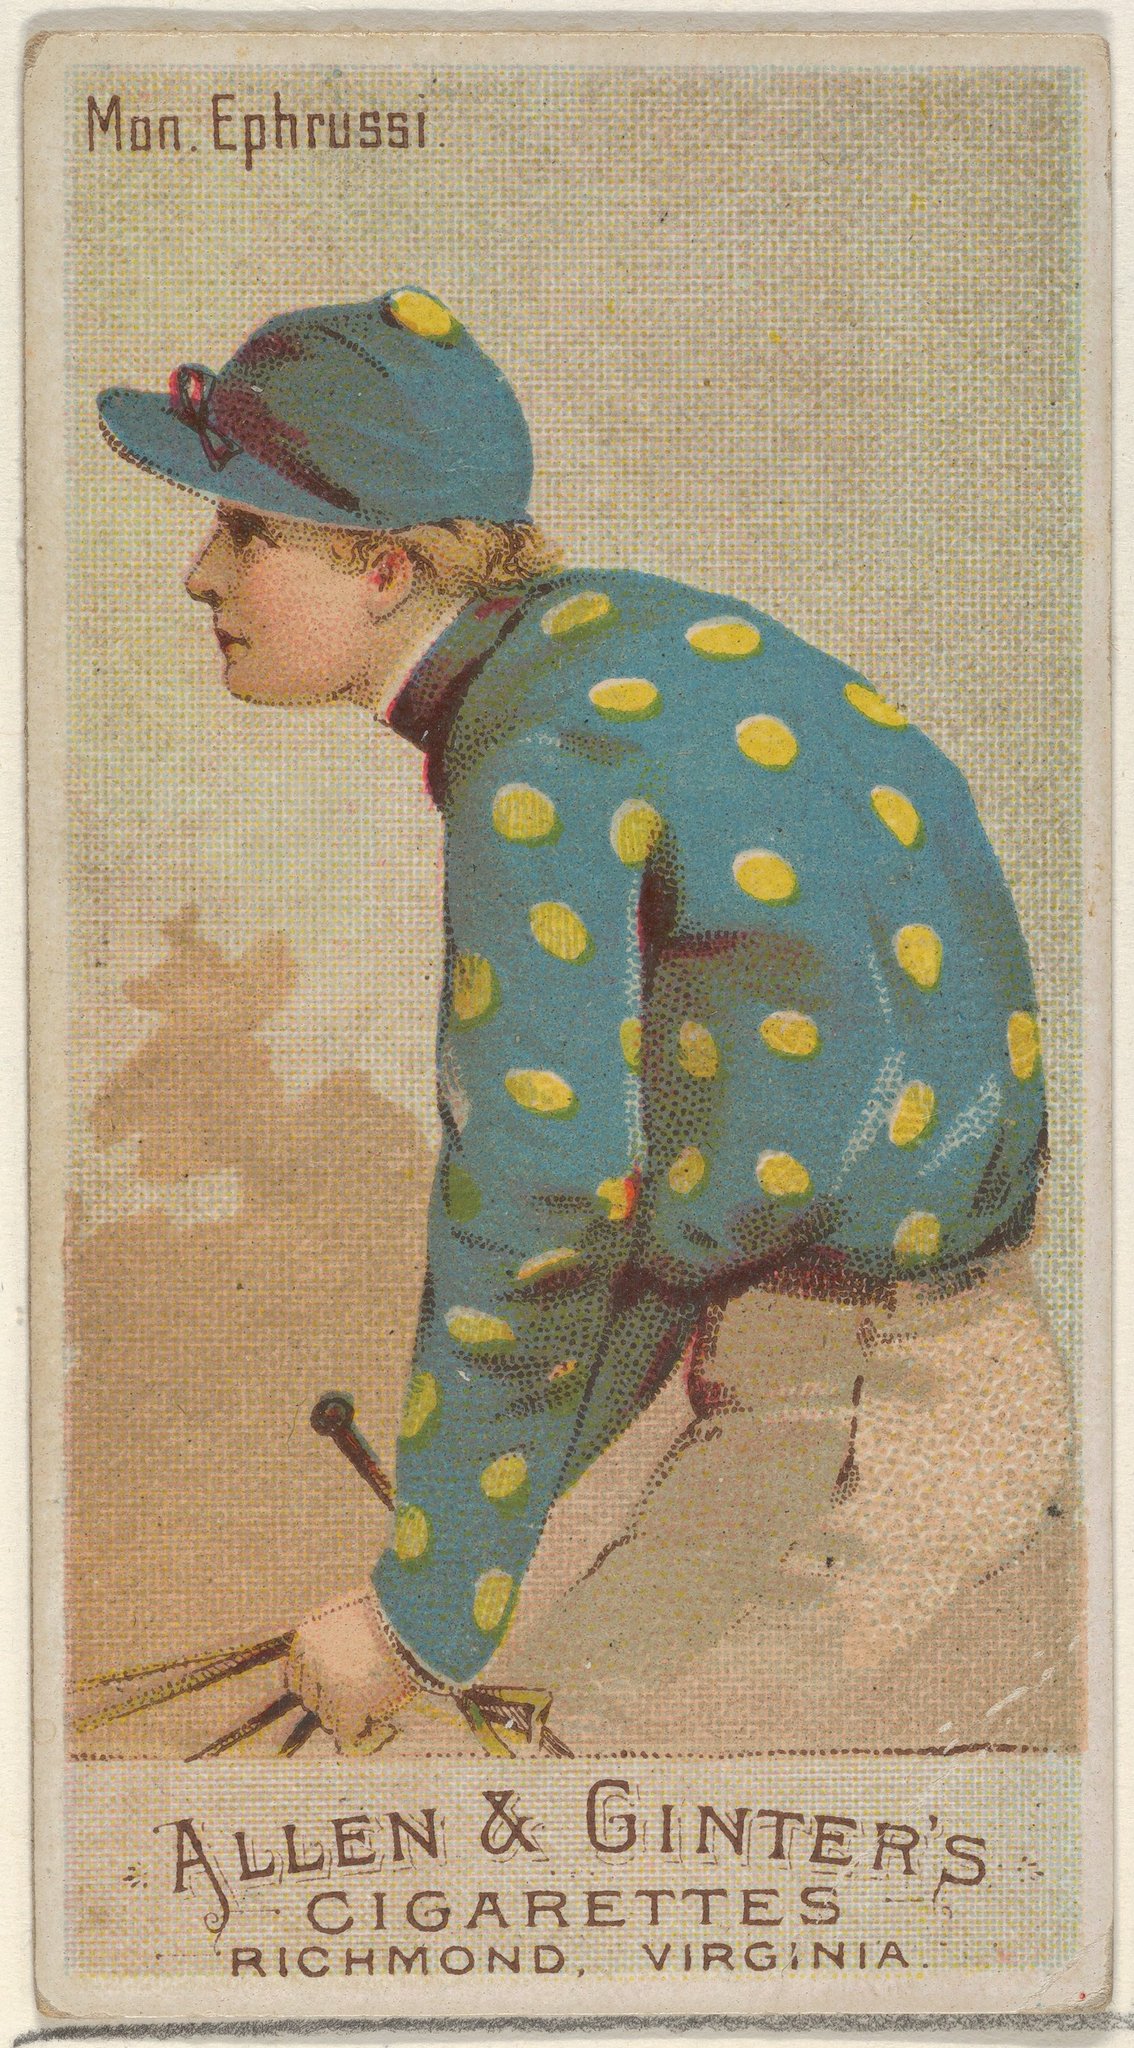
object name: print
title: Mon. Ephrussi, from the Racing Colors of the World series (N22a) for Allen & Ginter Cigarettes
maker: allen & ginter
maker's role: publisher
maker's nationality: american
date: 1888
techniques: color lithograph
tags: men,profiles,jockeys